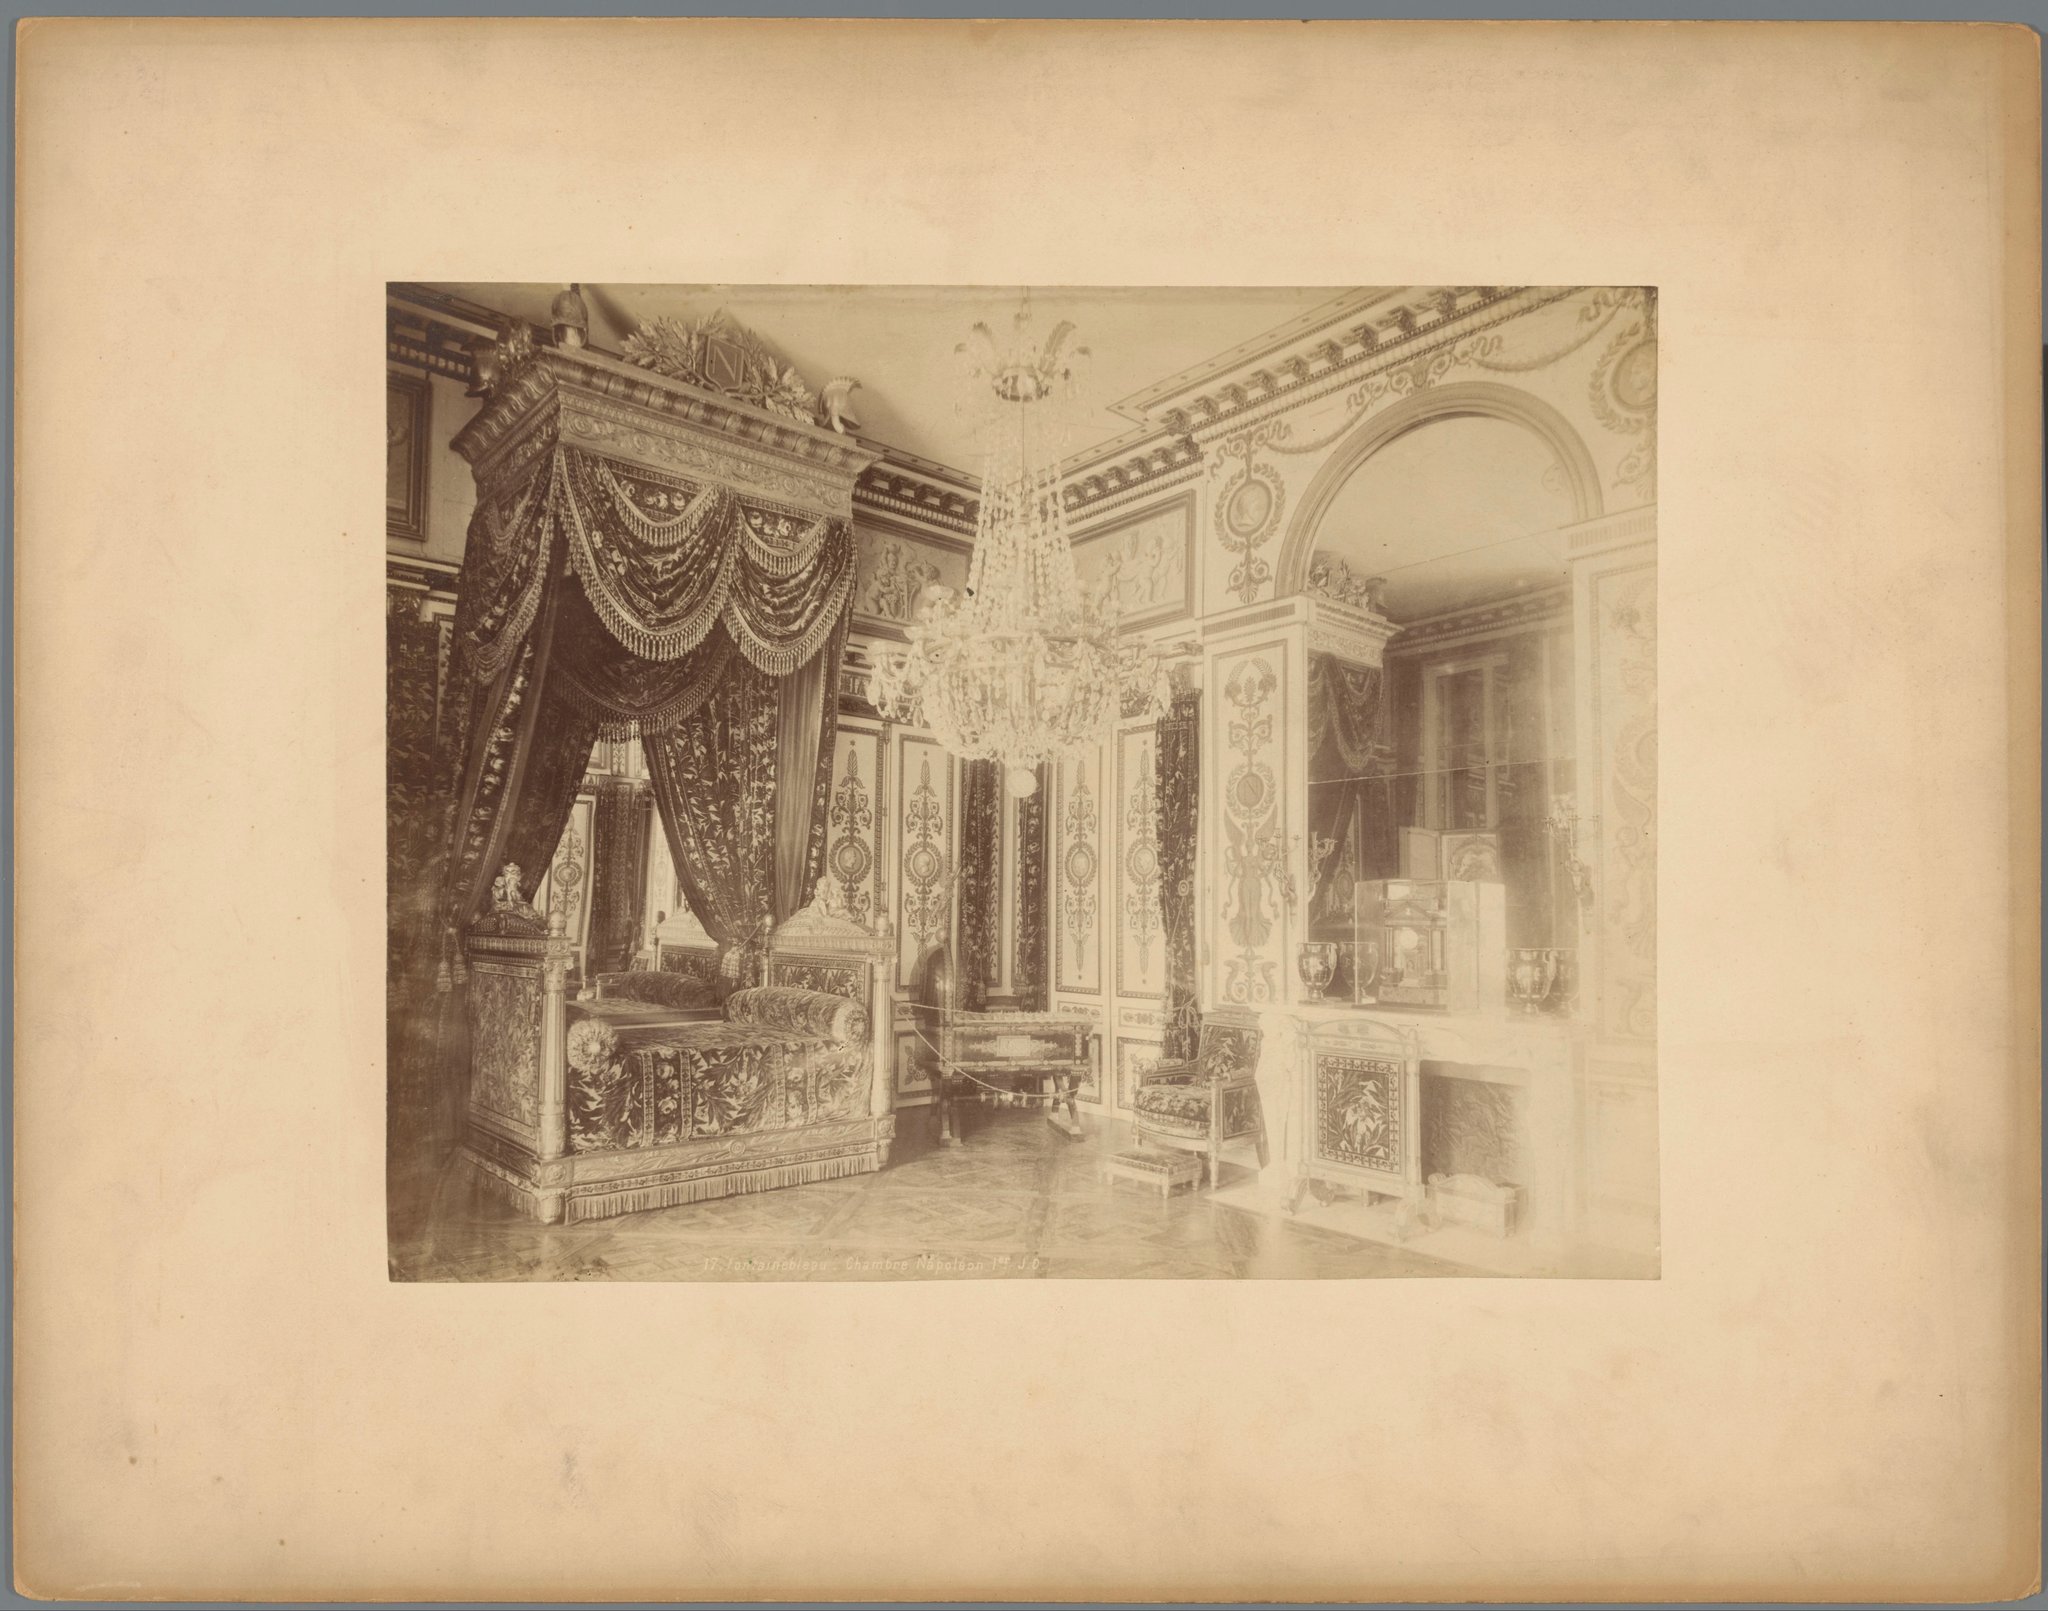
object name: photograph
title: Versailles - Cabinet de travail (Gd. Trianon)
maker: jd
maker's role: fotograaf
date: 1875-1900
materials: cardboard, photographic support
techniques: albumen print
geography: grand trianon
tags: bench, chandelier, candelabrum, palace, interior of the house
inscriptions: number: ‘51’, collector's mark: Lugt 3937